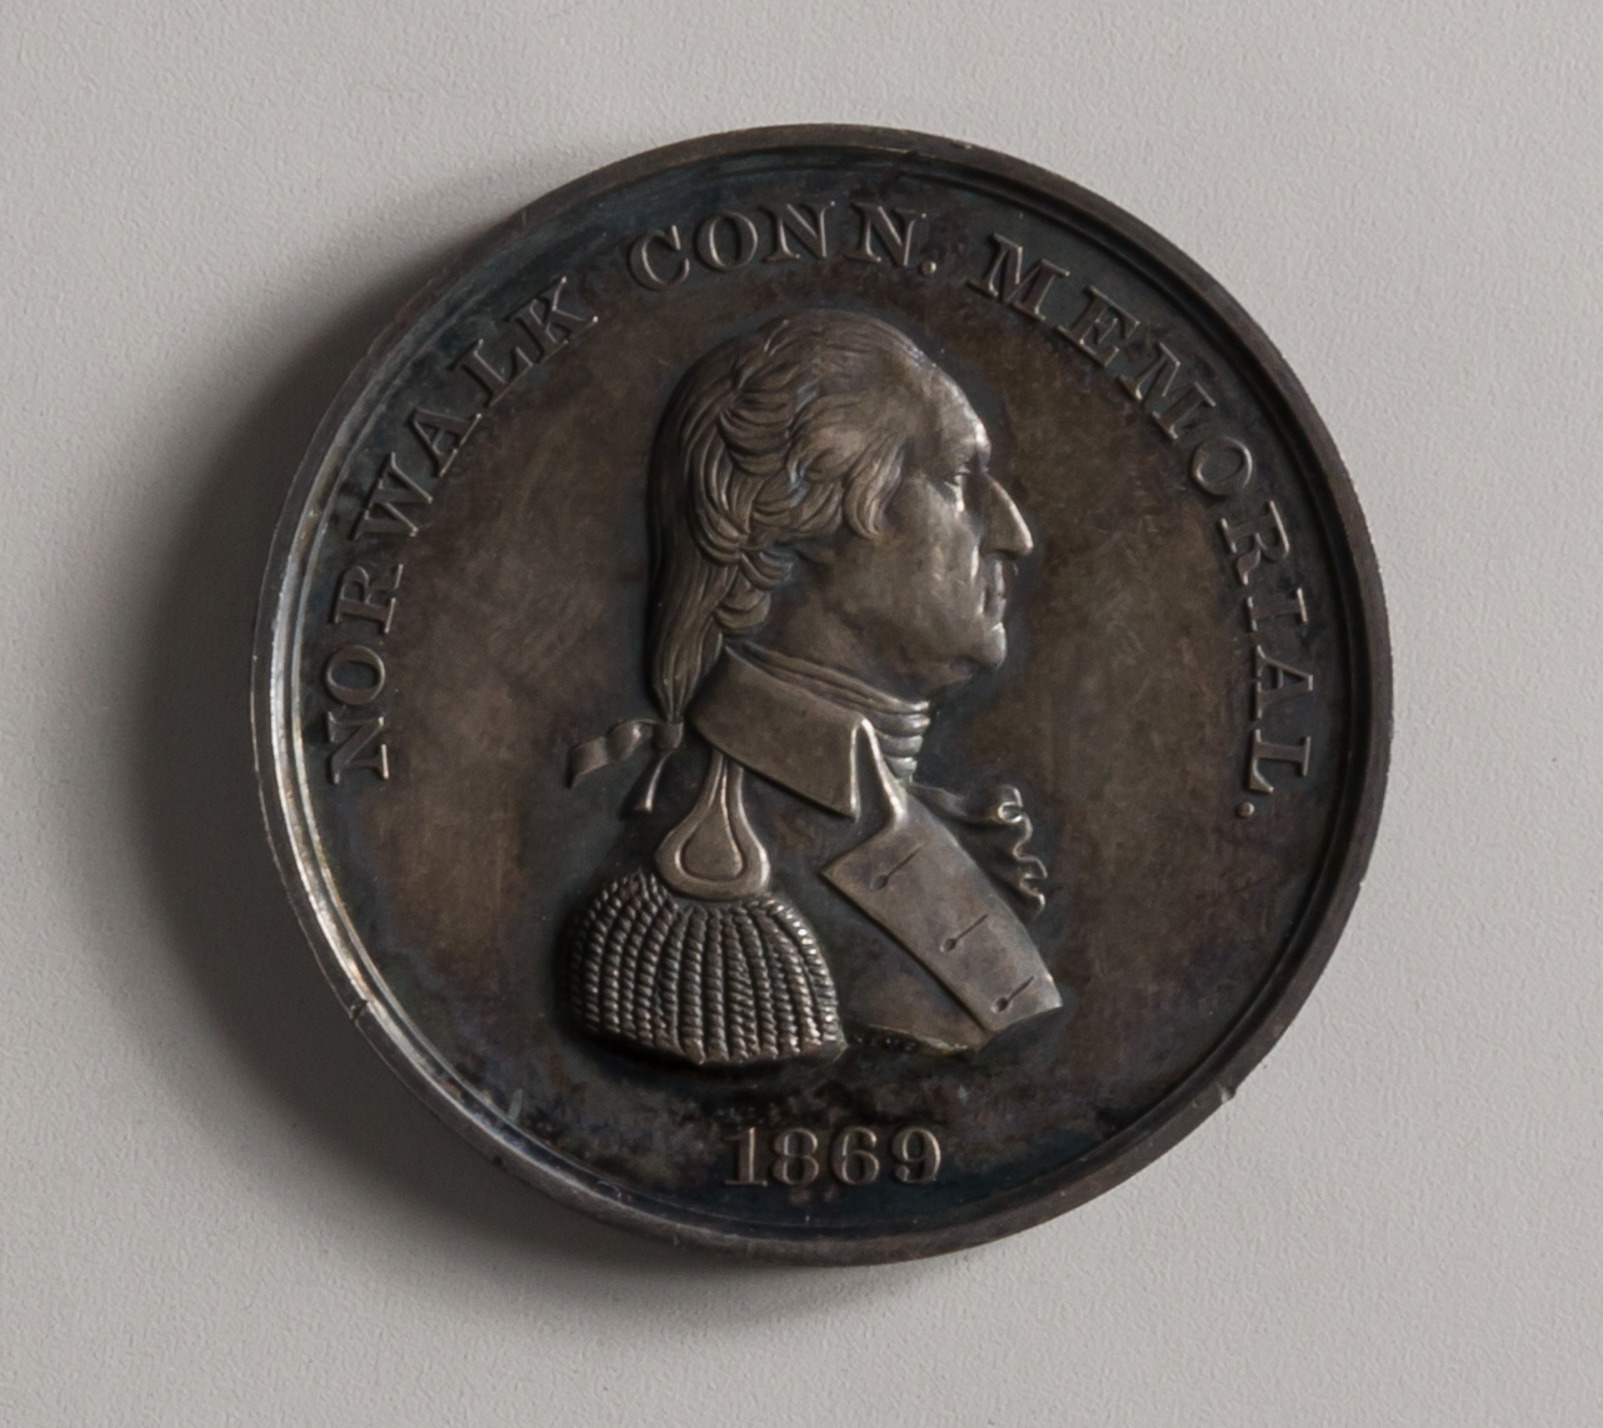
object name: medal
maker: william h. key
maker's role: maker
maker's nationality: american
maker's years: 1828-1928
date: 1869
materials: metal, silver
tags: men,profiles